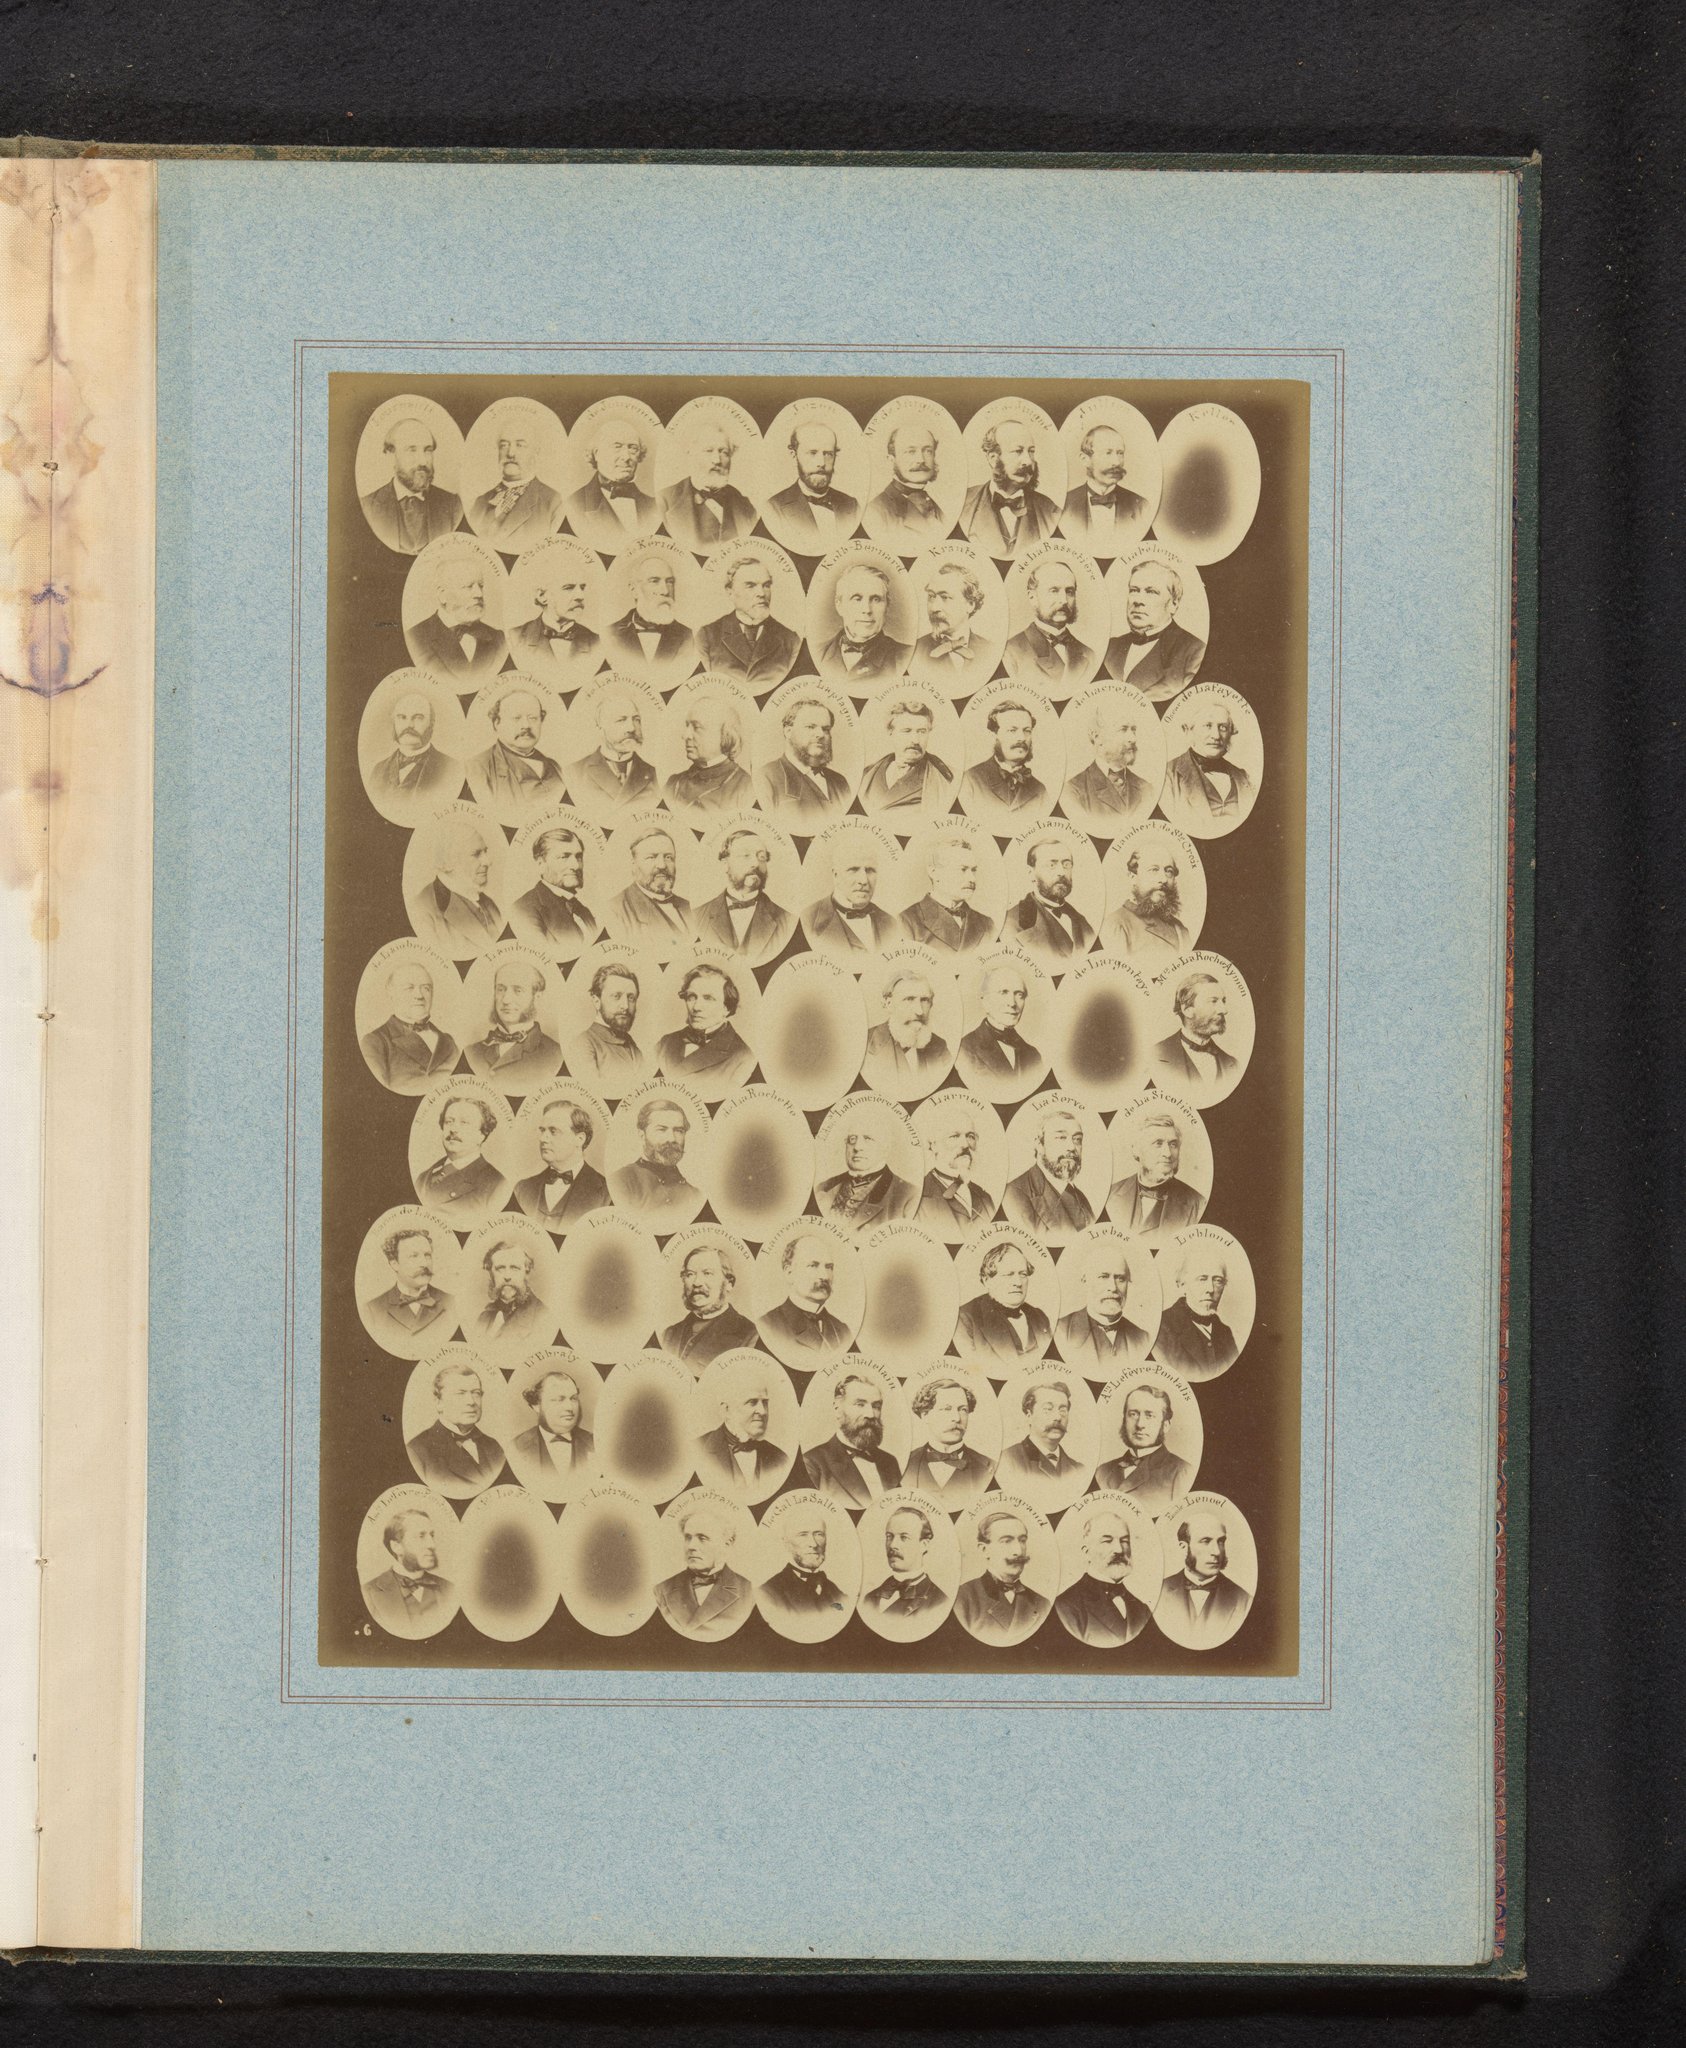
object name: montagefoto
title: Samengesteld groepsportret van leden van de Assembée Nationale van 1873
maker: françois marie louis franck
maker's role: fotograaf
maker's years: 1816-1906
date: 1868-1873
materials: photographic support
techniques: albumen print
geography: france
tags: politician, e.g. party leader, lower house, parliament, chamber, anonymous historical persons portrayed in a group, in a group-portrait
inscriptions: number: ‘.6’